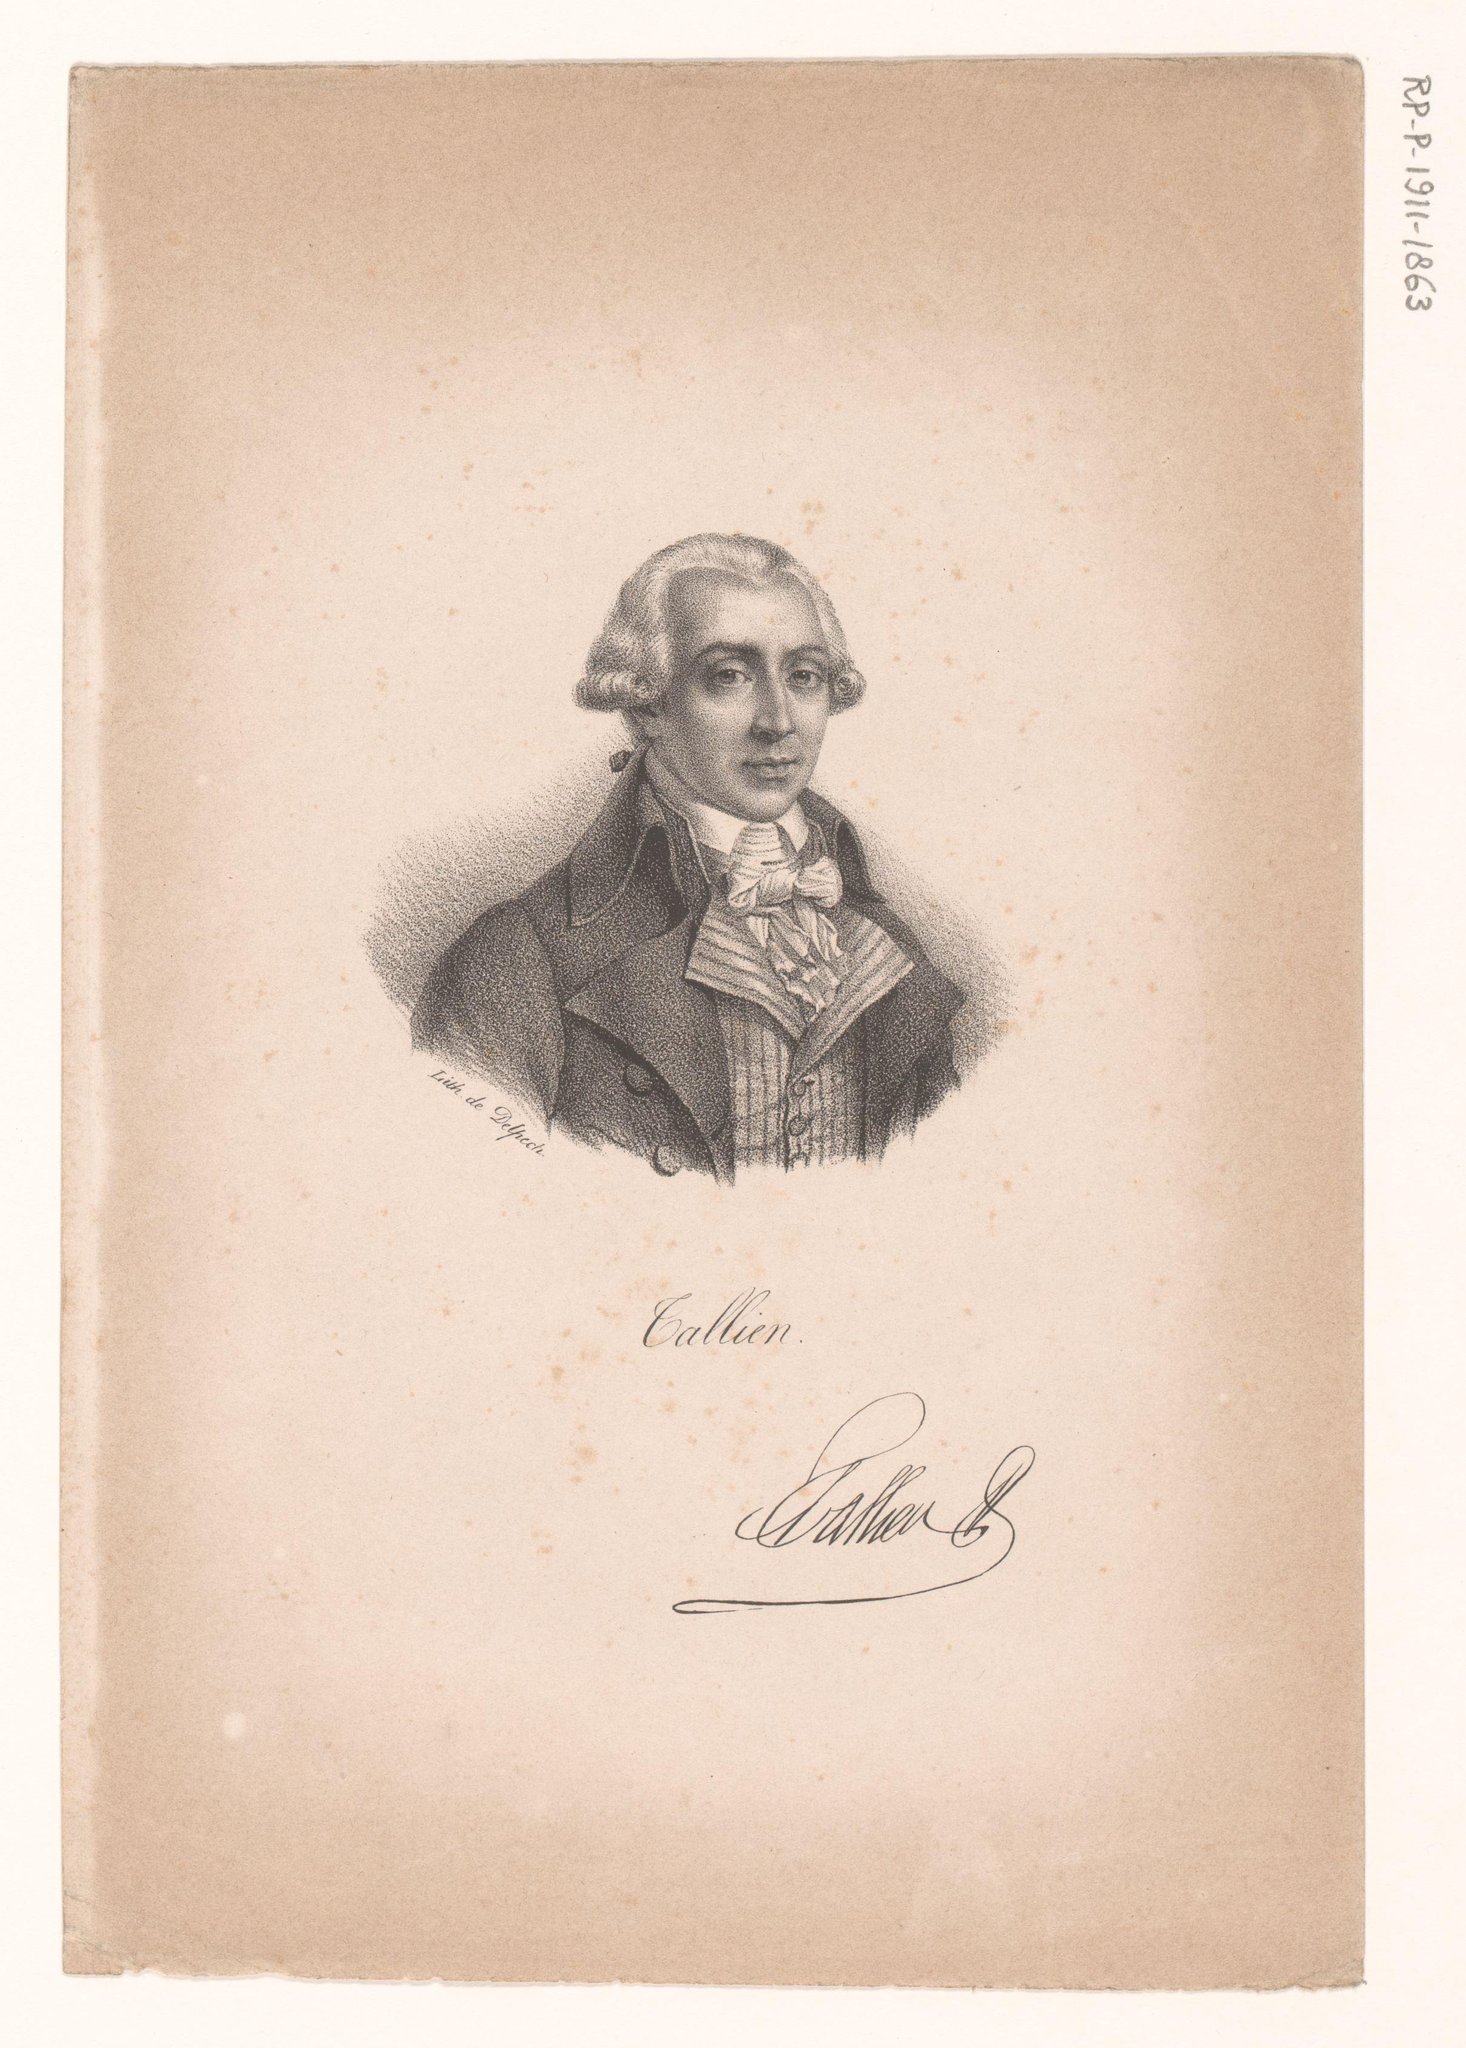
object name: print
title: Tallien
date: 1818-1842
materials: paper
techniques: lithograph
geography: paris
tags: paris, historical persons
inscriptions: collector's mark: Lugt 2228a